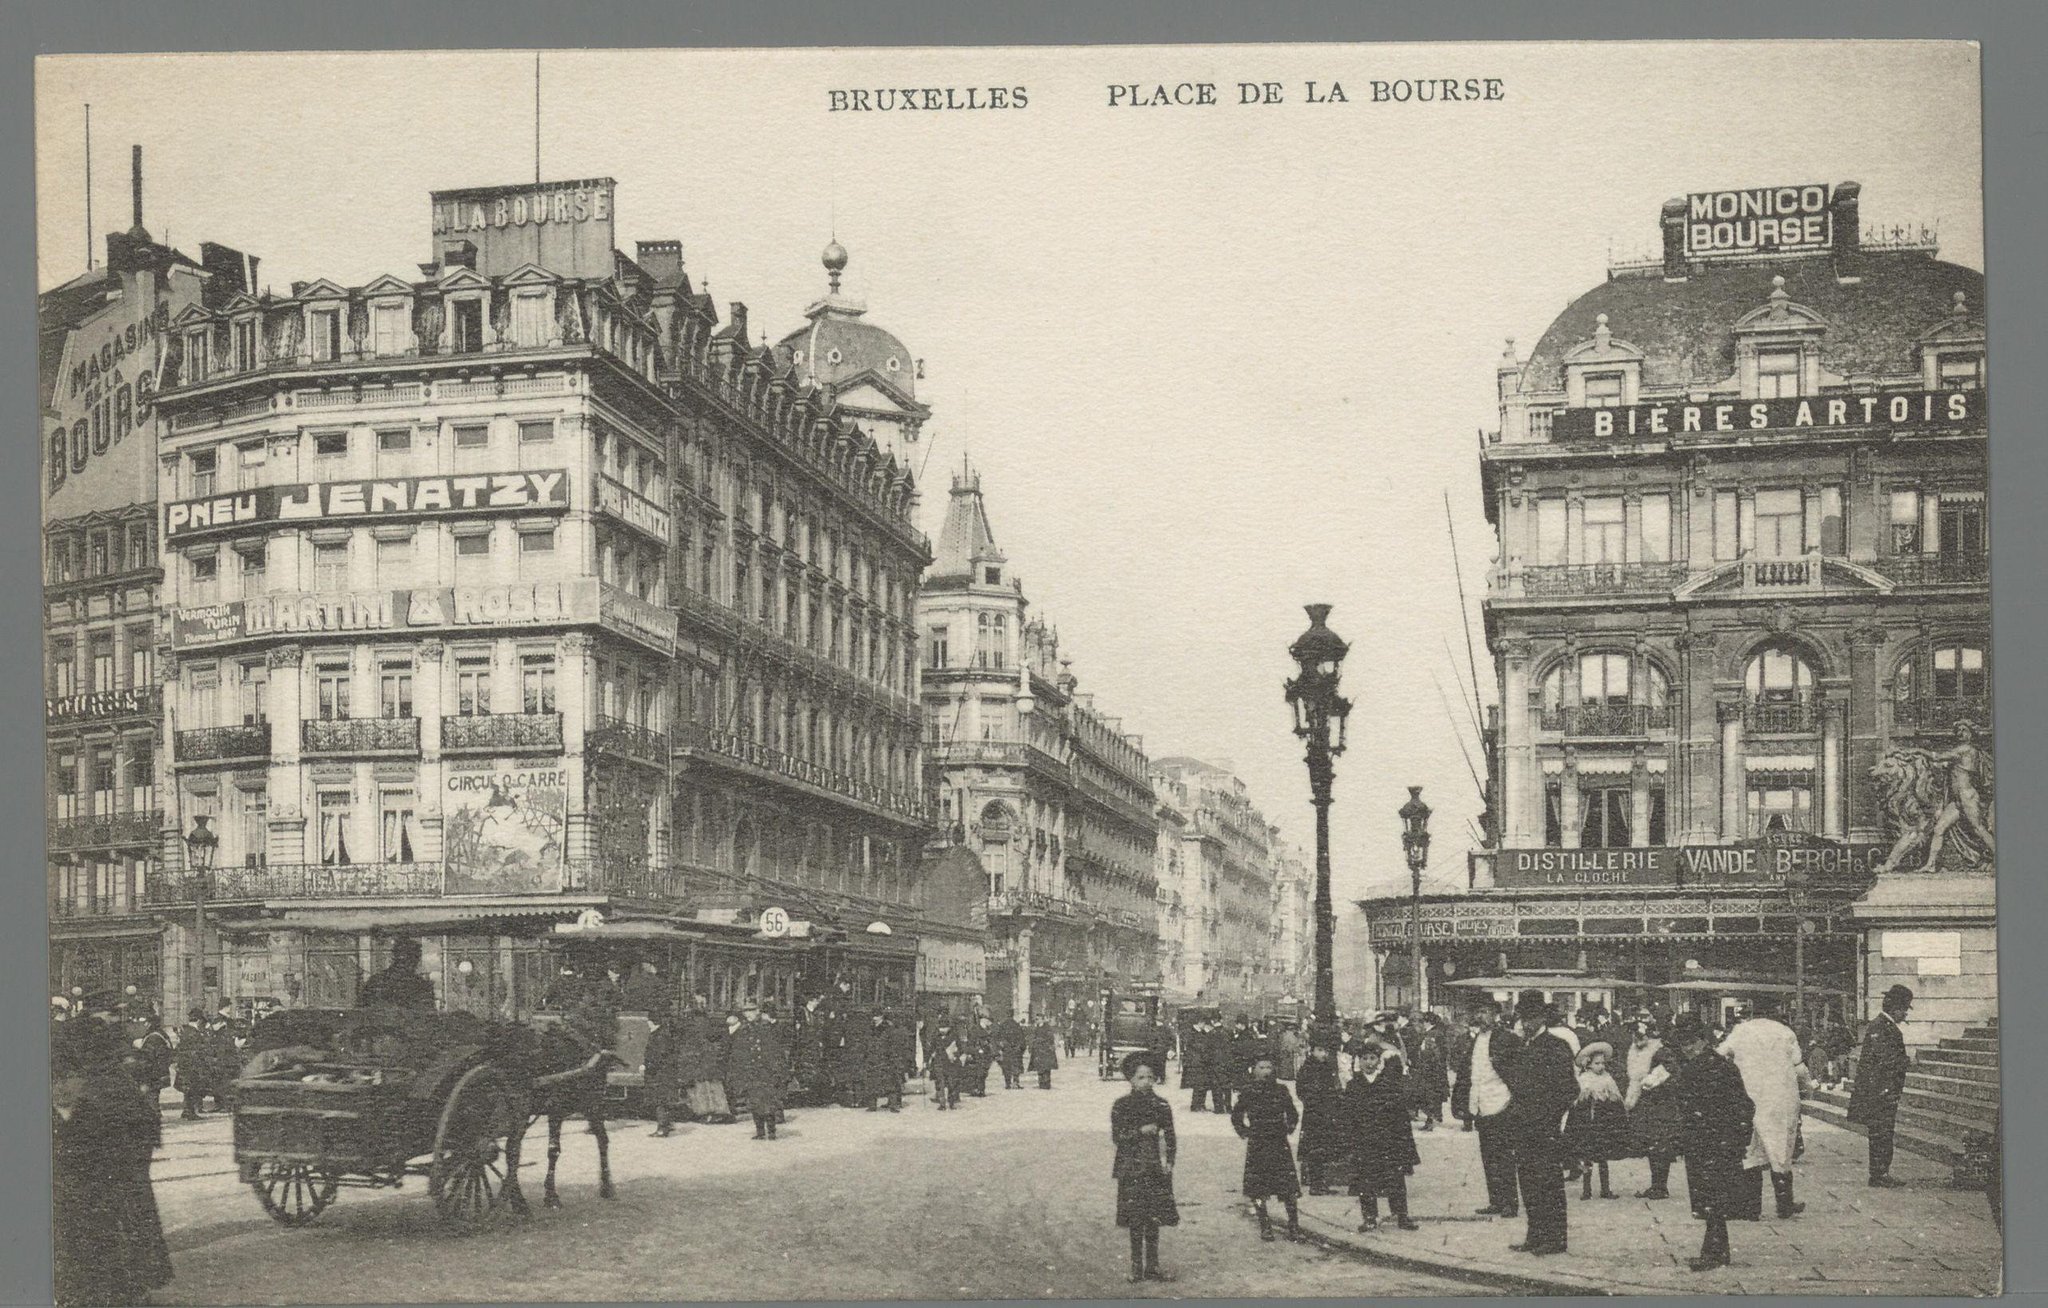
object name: ansichtkaart, prentbriefkaart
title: Bruxelles. Place de la Bourse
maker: Anonymous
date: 1906-1930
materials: cardboard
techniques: photograph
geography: brussels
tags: city-view, and landscape with man-made constructions (+ city(-scape) with figures, staffage), square, place, circus, etc. (+ city(-scape) with figures, staffage), brussels